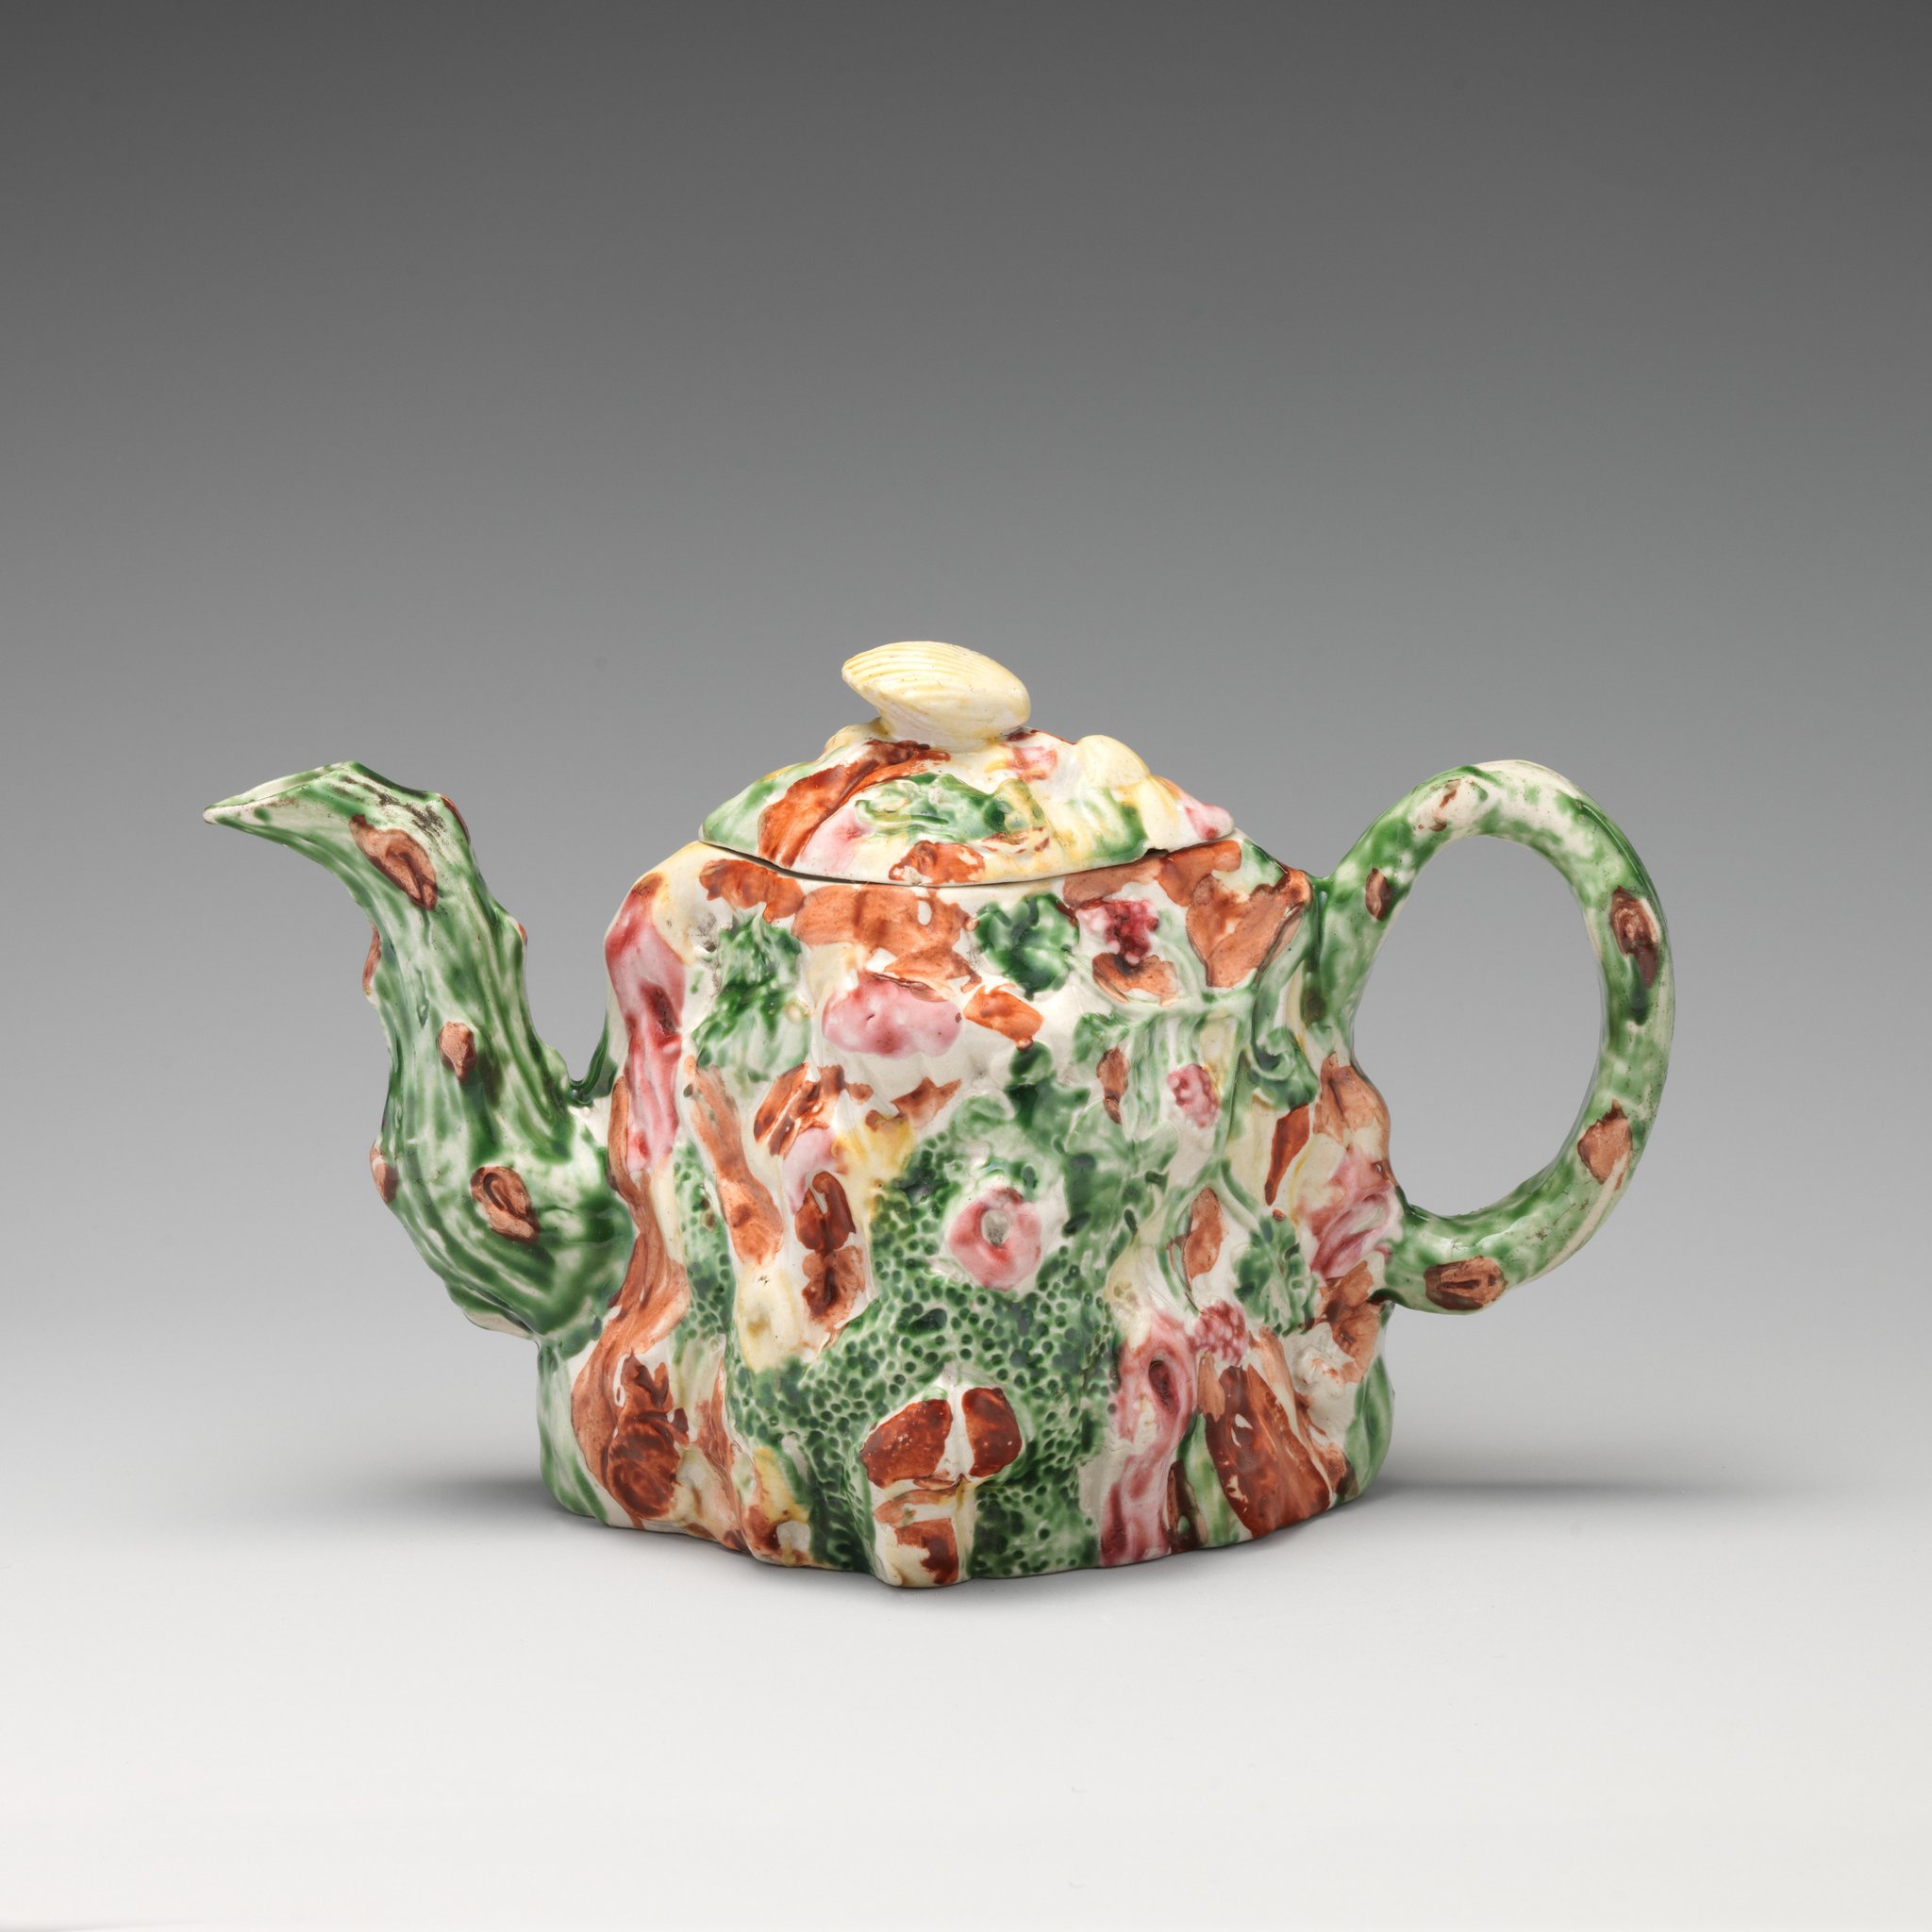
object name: teapot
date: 1755-1760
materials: enamel, stoneware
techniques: salt glaze